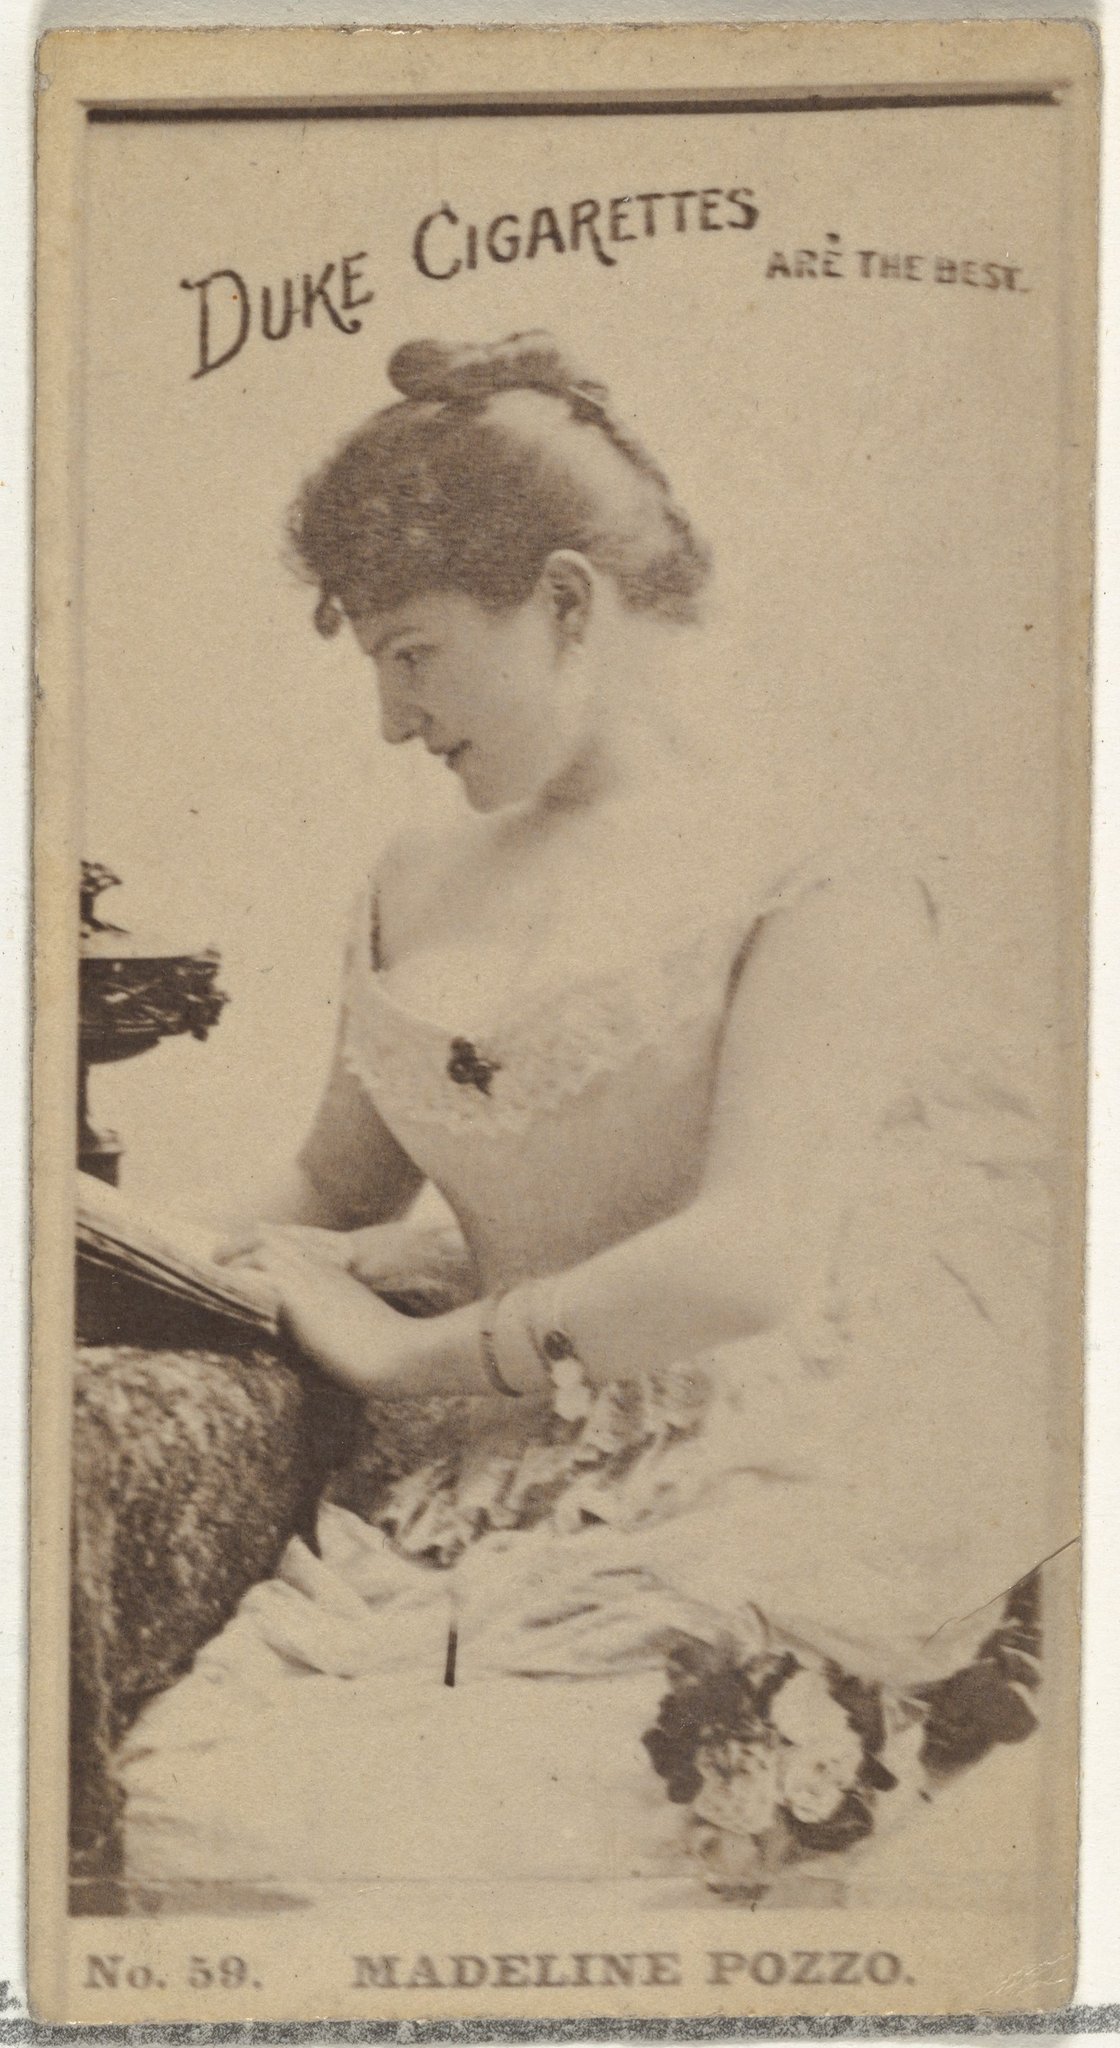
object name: photograph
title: Card Number 59, Madeline Pozzo, from the Actors and Actresses series (N145-6) issued by Duke Sons & Co. to promote Duke Cigarettes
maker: w. duke, sons & co.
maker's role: publisher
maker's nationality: american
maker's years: 1870-1920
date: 1880-1889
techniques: albumen silver print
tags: women,actresses